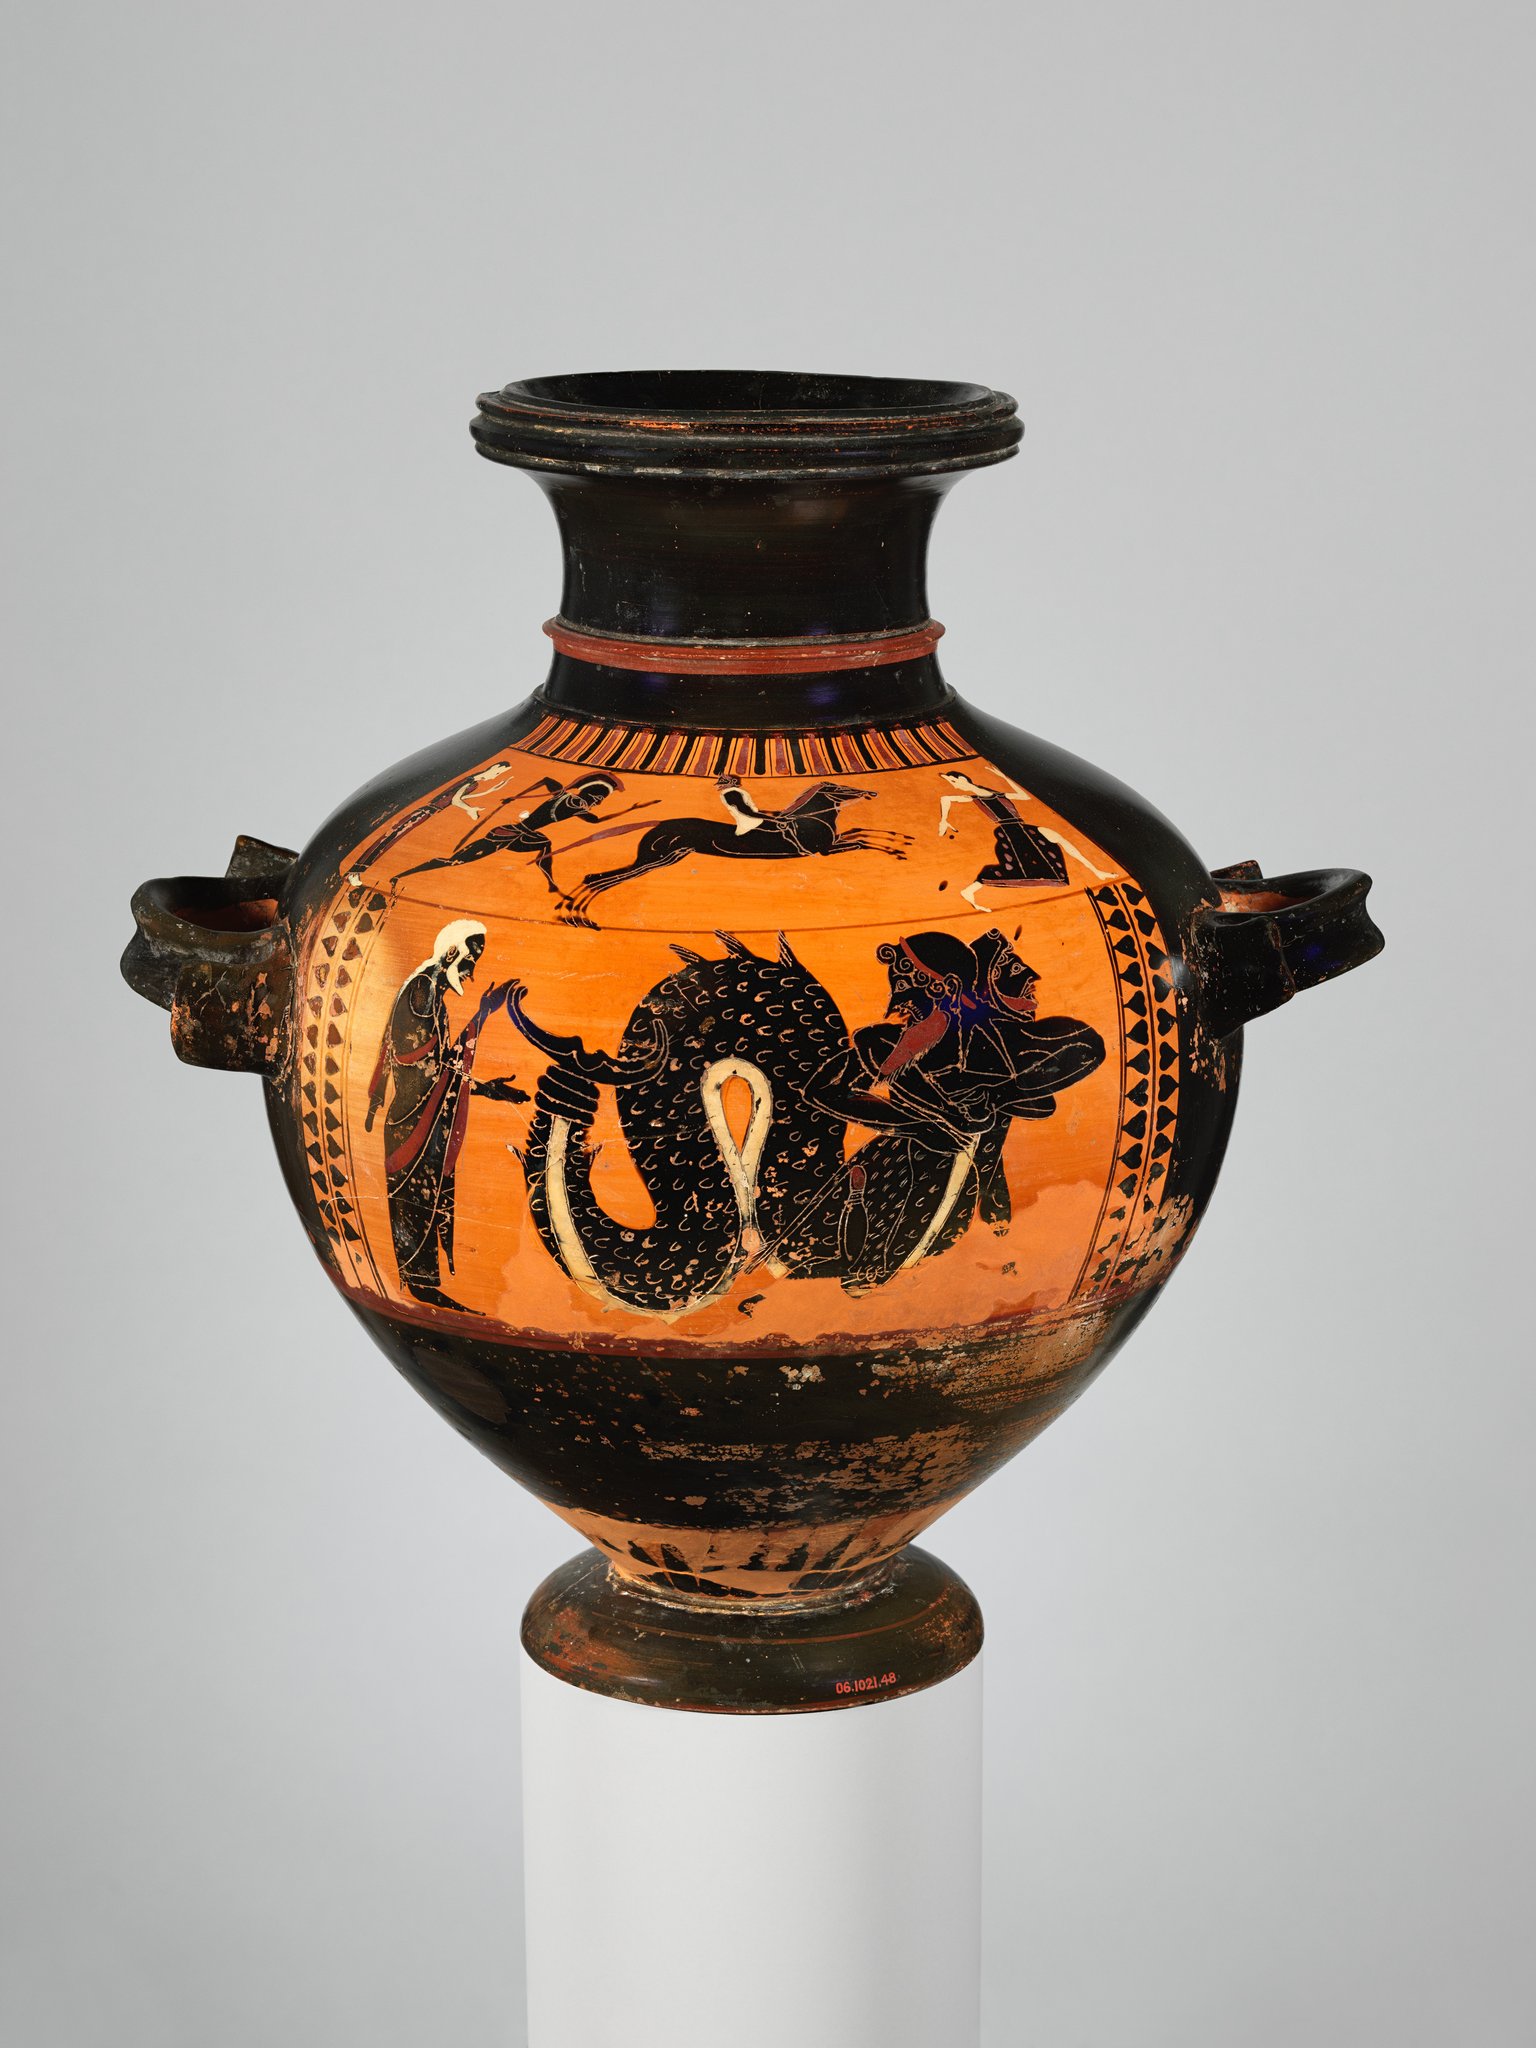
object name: hydria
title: Terracotta hydria (water jar)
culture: greek, attic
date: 560-550 BCE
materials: terracotta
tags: triton,achilles,horses,herakles